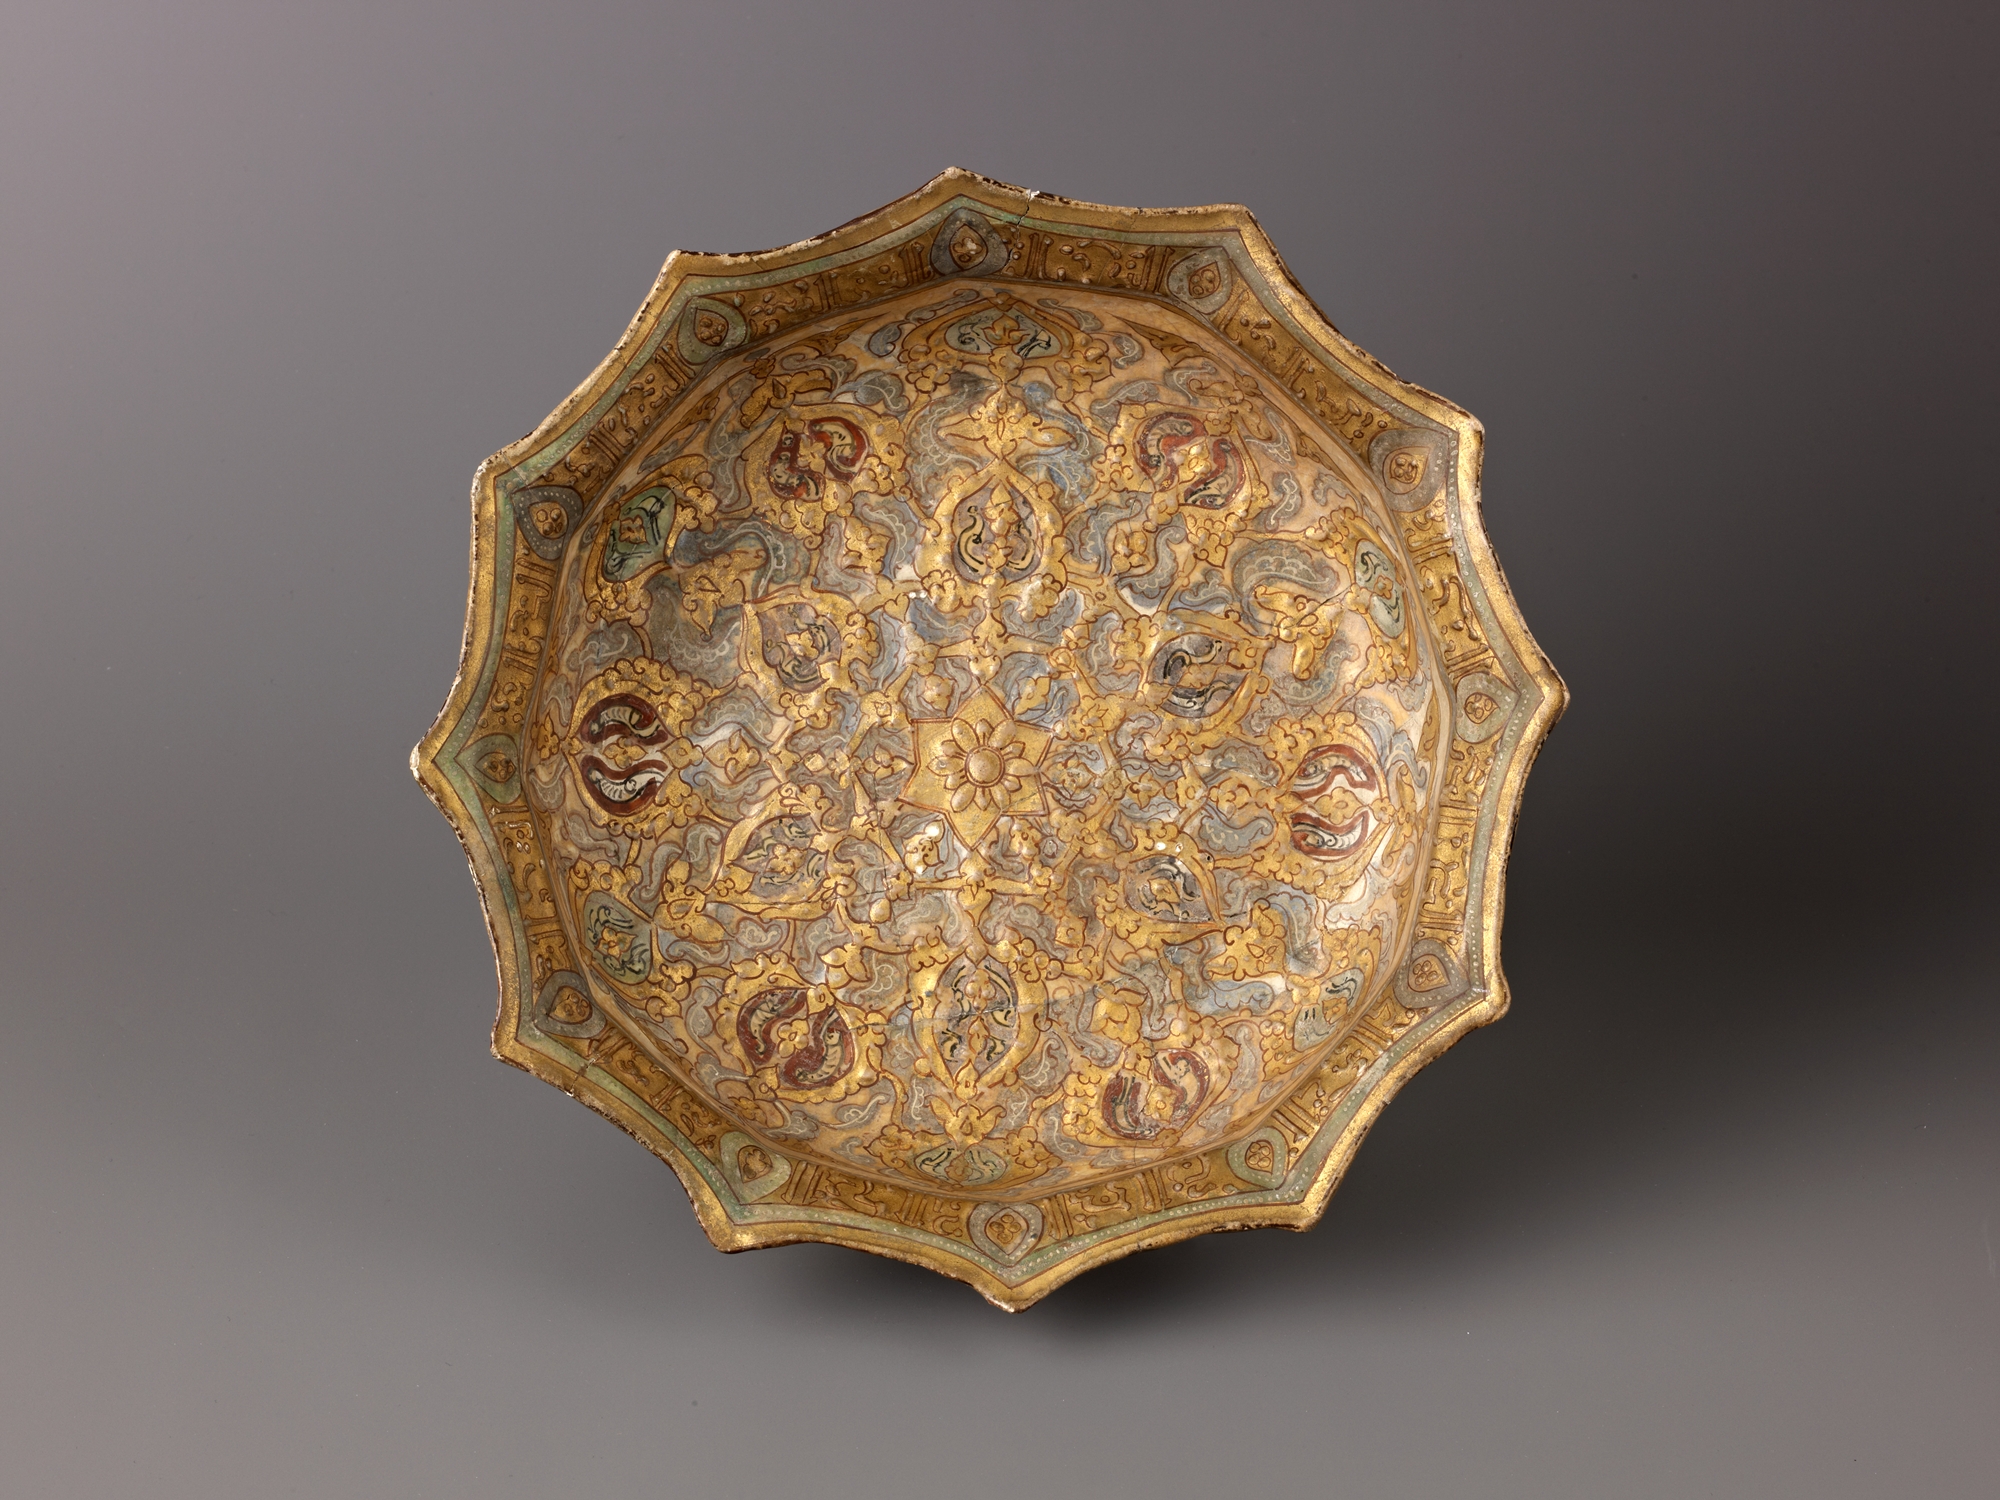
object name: basin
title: Faceted Basin, Mina'i ("enameled") ware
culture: iranian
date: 1201-1233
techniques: gilding, overglaze, painting